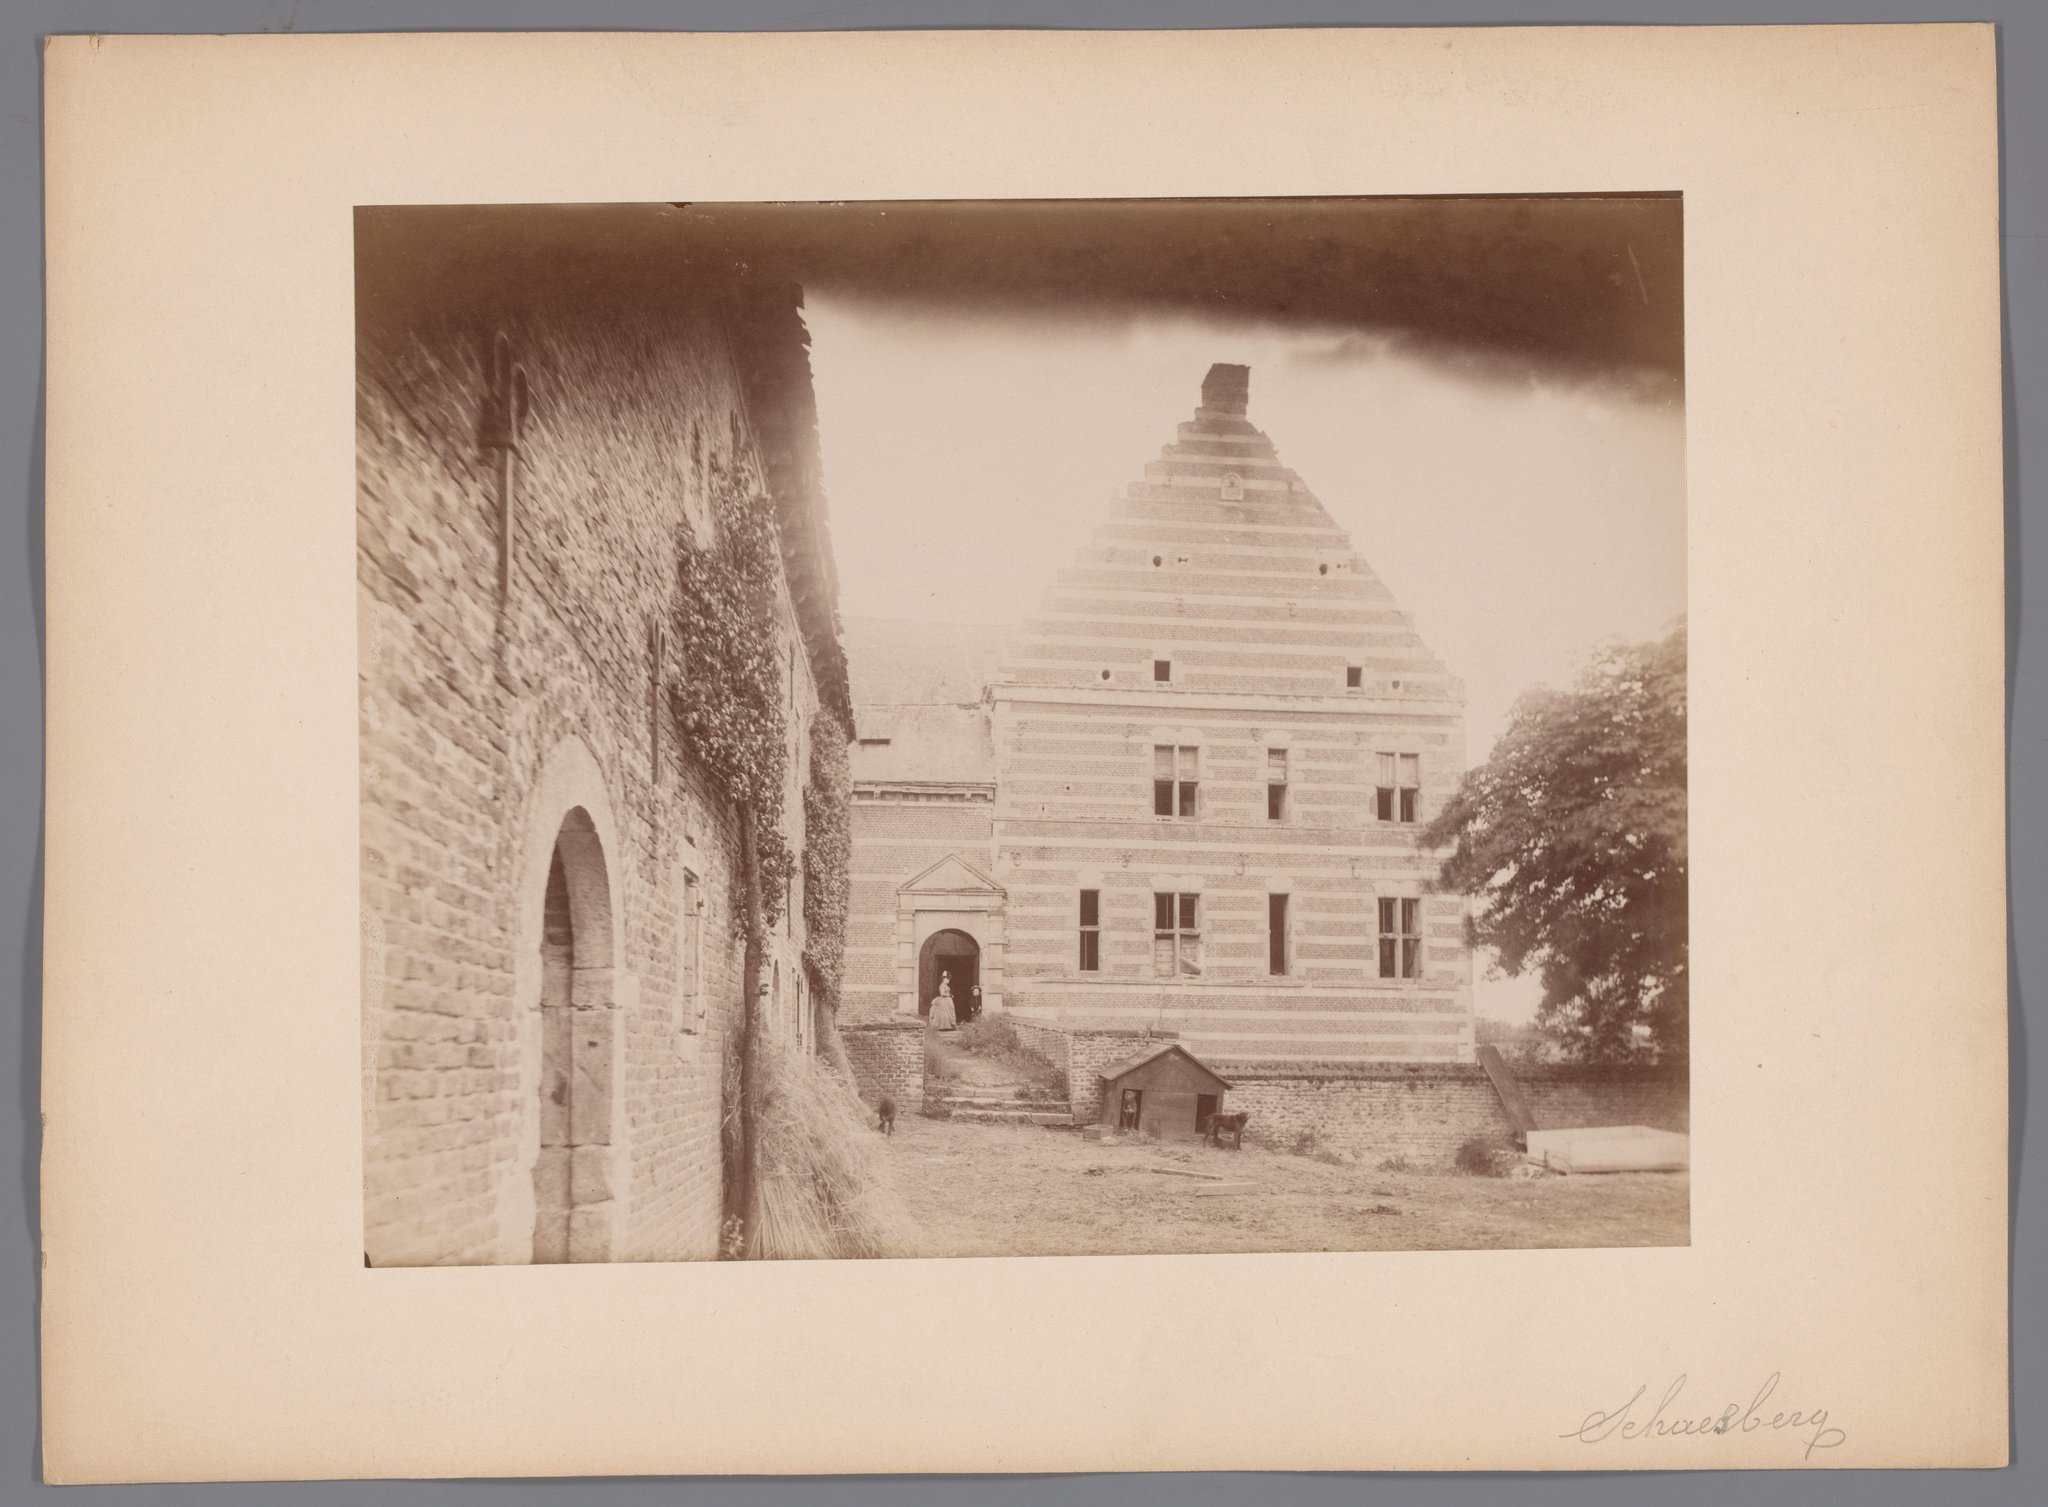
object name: photograph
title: Gezicht op Kasteel Schaesberg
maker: anoniem (monumentenzorg)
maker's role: fotograaf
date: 1890-1920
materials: cardboard, photographic support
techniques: albumen print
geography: schaesberg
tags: castle, dog (+ stable, shed, kennel)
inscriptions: annotation: ‘Schaesberg kasteel’, annotation: ‘Schaesberg’